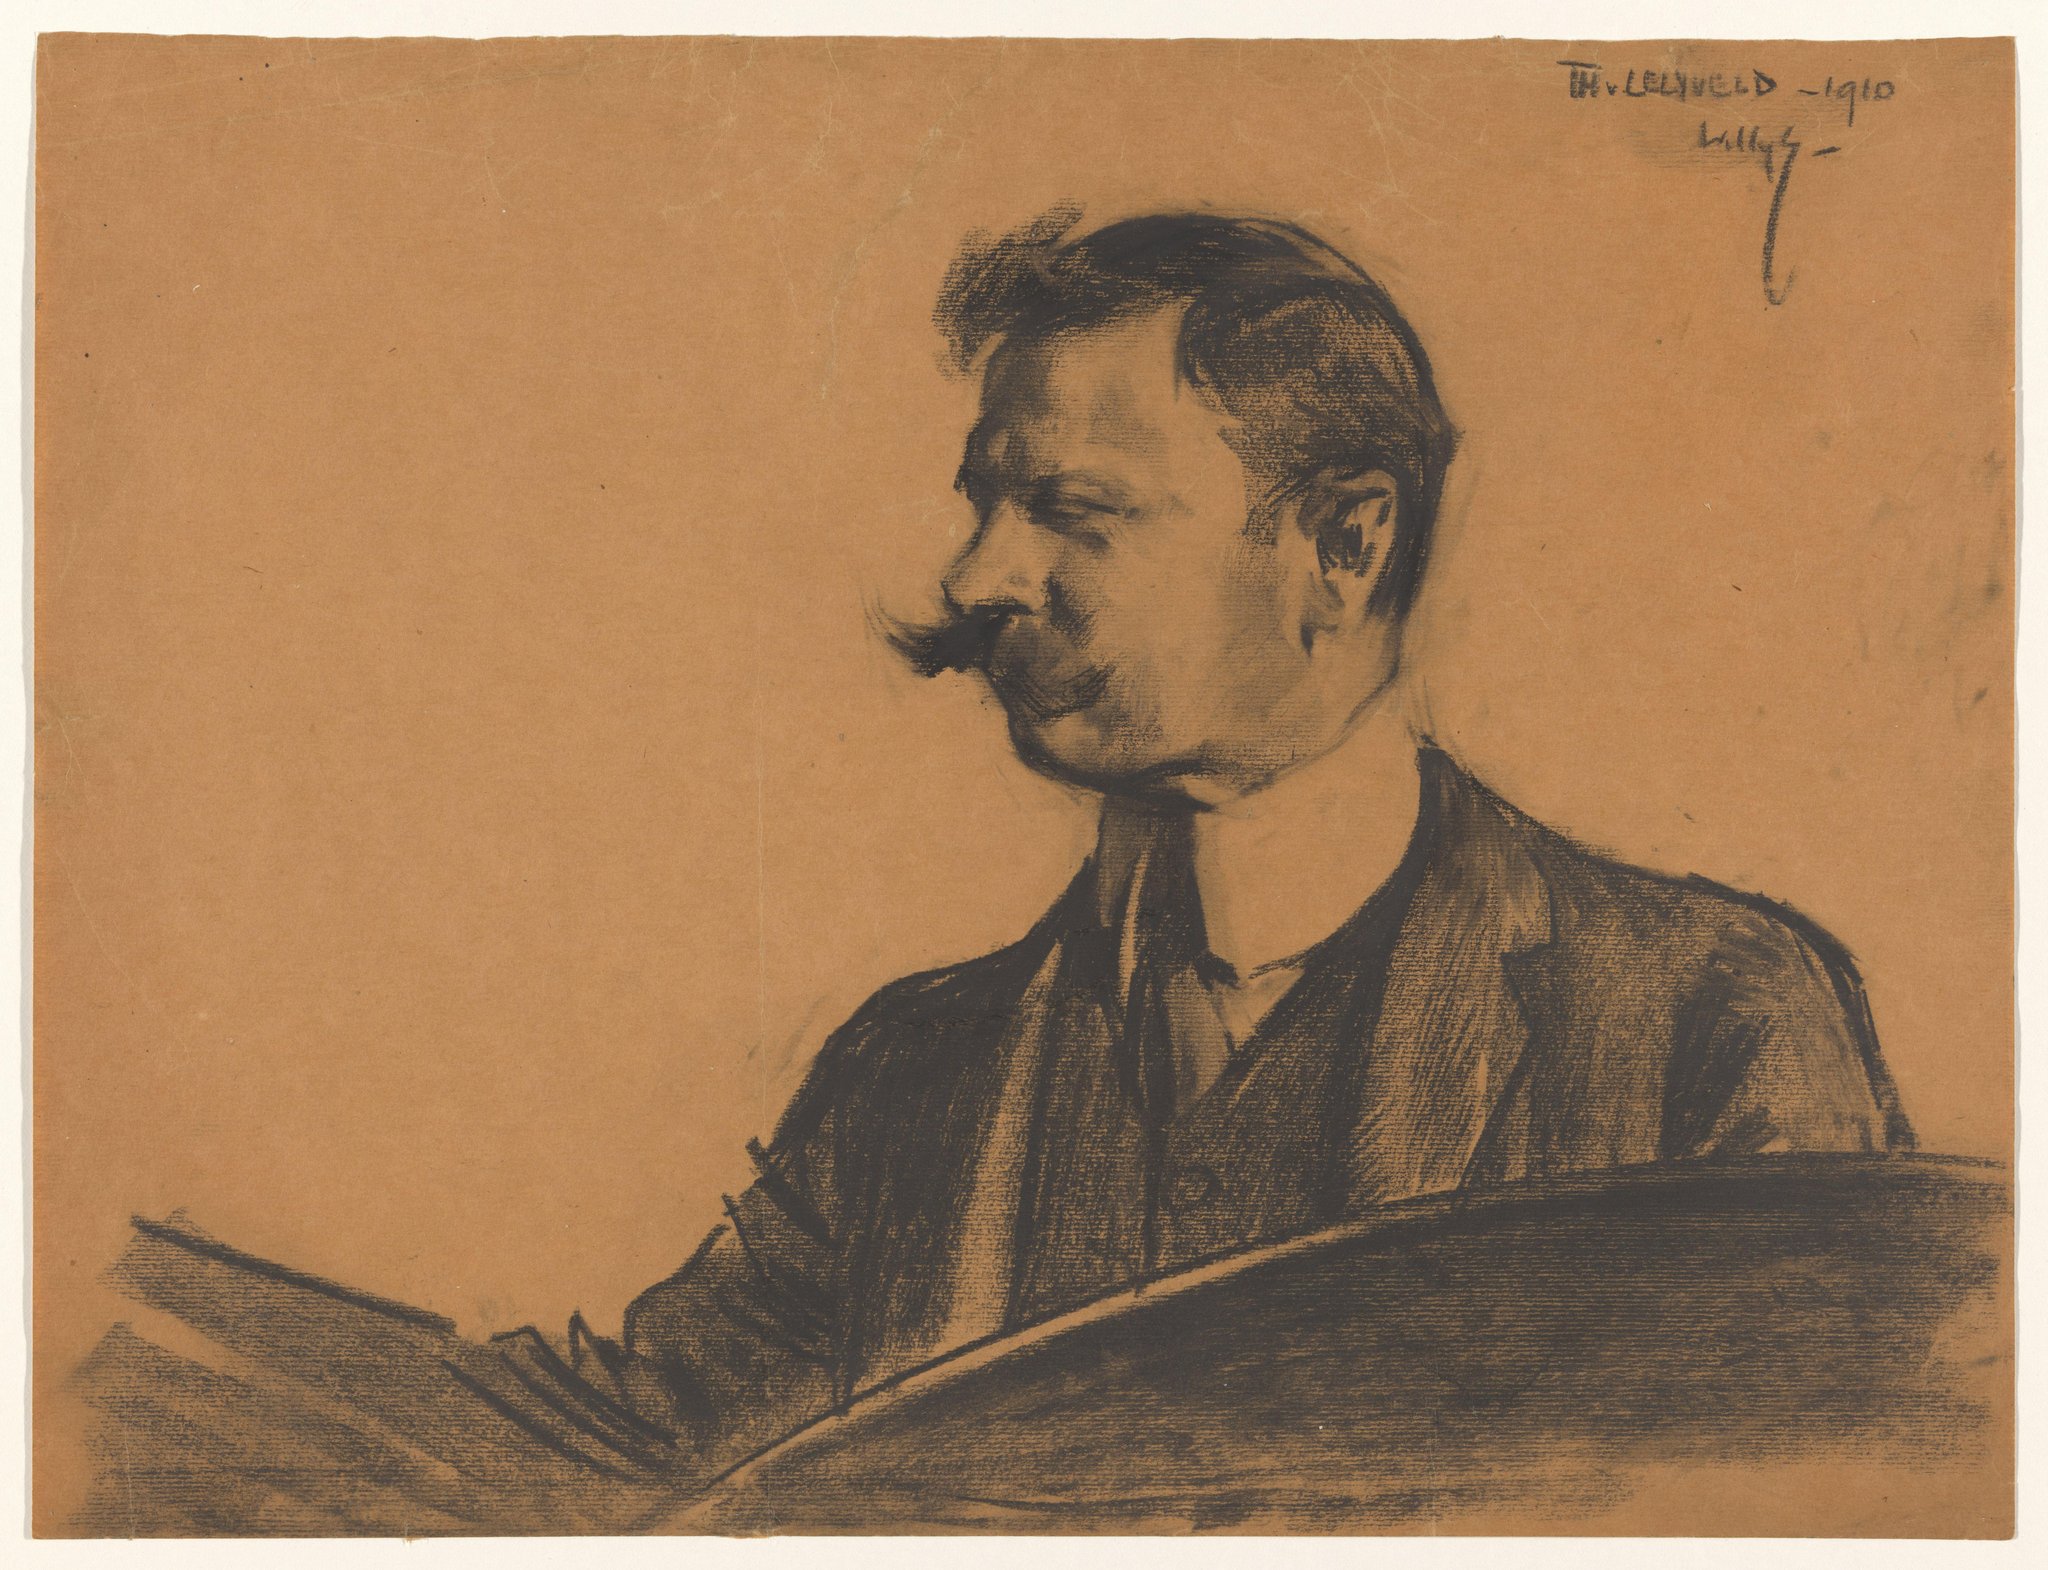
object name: drawing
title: Portret van Théodore B. van Lelyveld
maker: willy sluiter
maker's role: draughtsman, painter, print maker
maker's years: 1873-1949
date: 1910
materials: charcoal, paper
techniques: drawing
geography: netherlands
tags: painter, théodore van lelyveld, historical persons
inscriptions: signature and date: ‘TH v LELYVELD - 1910 / Willy S-’